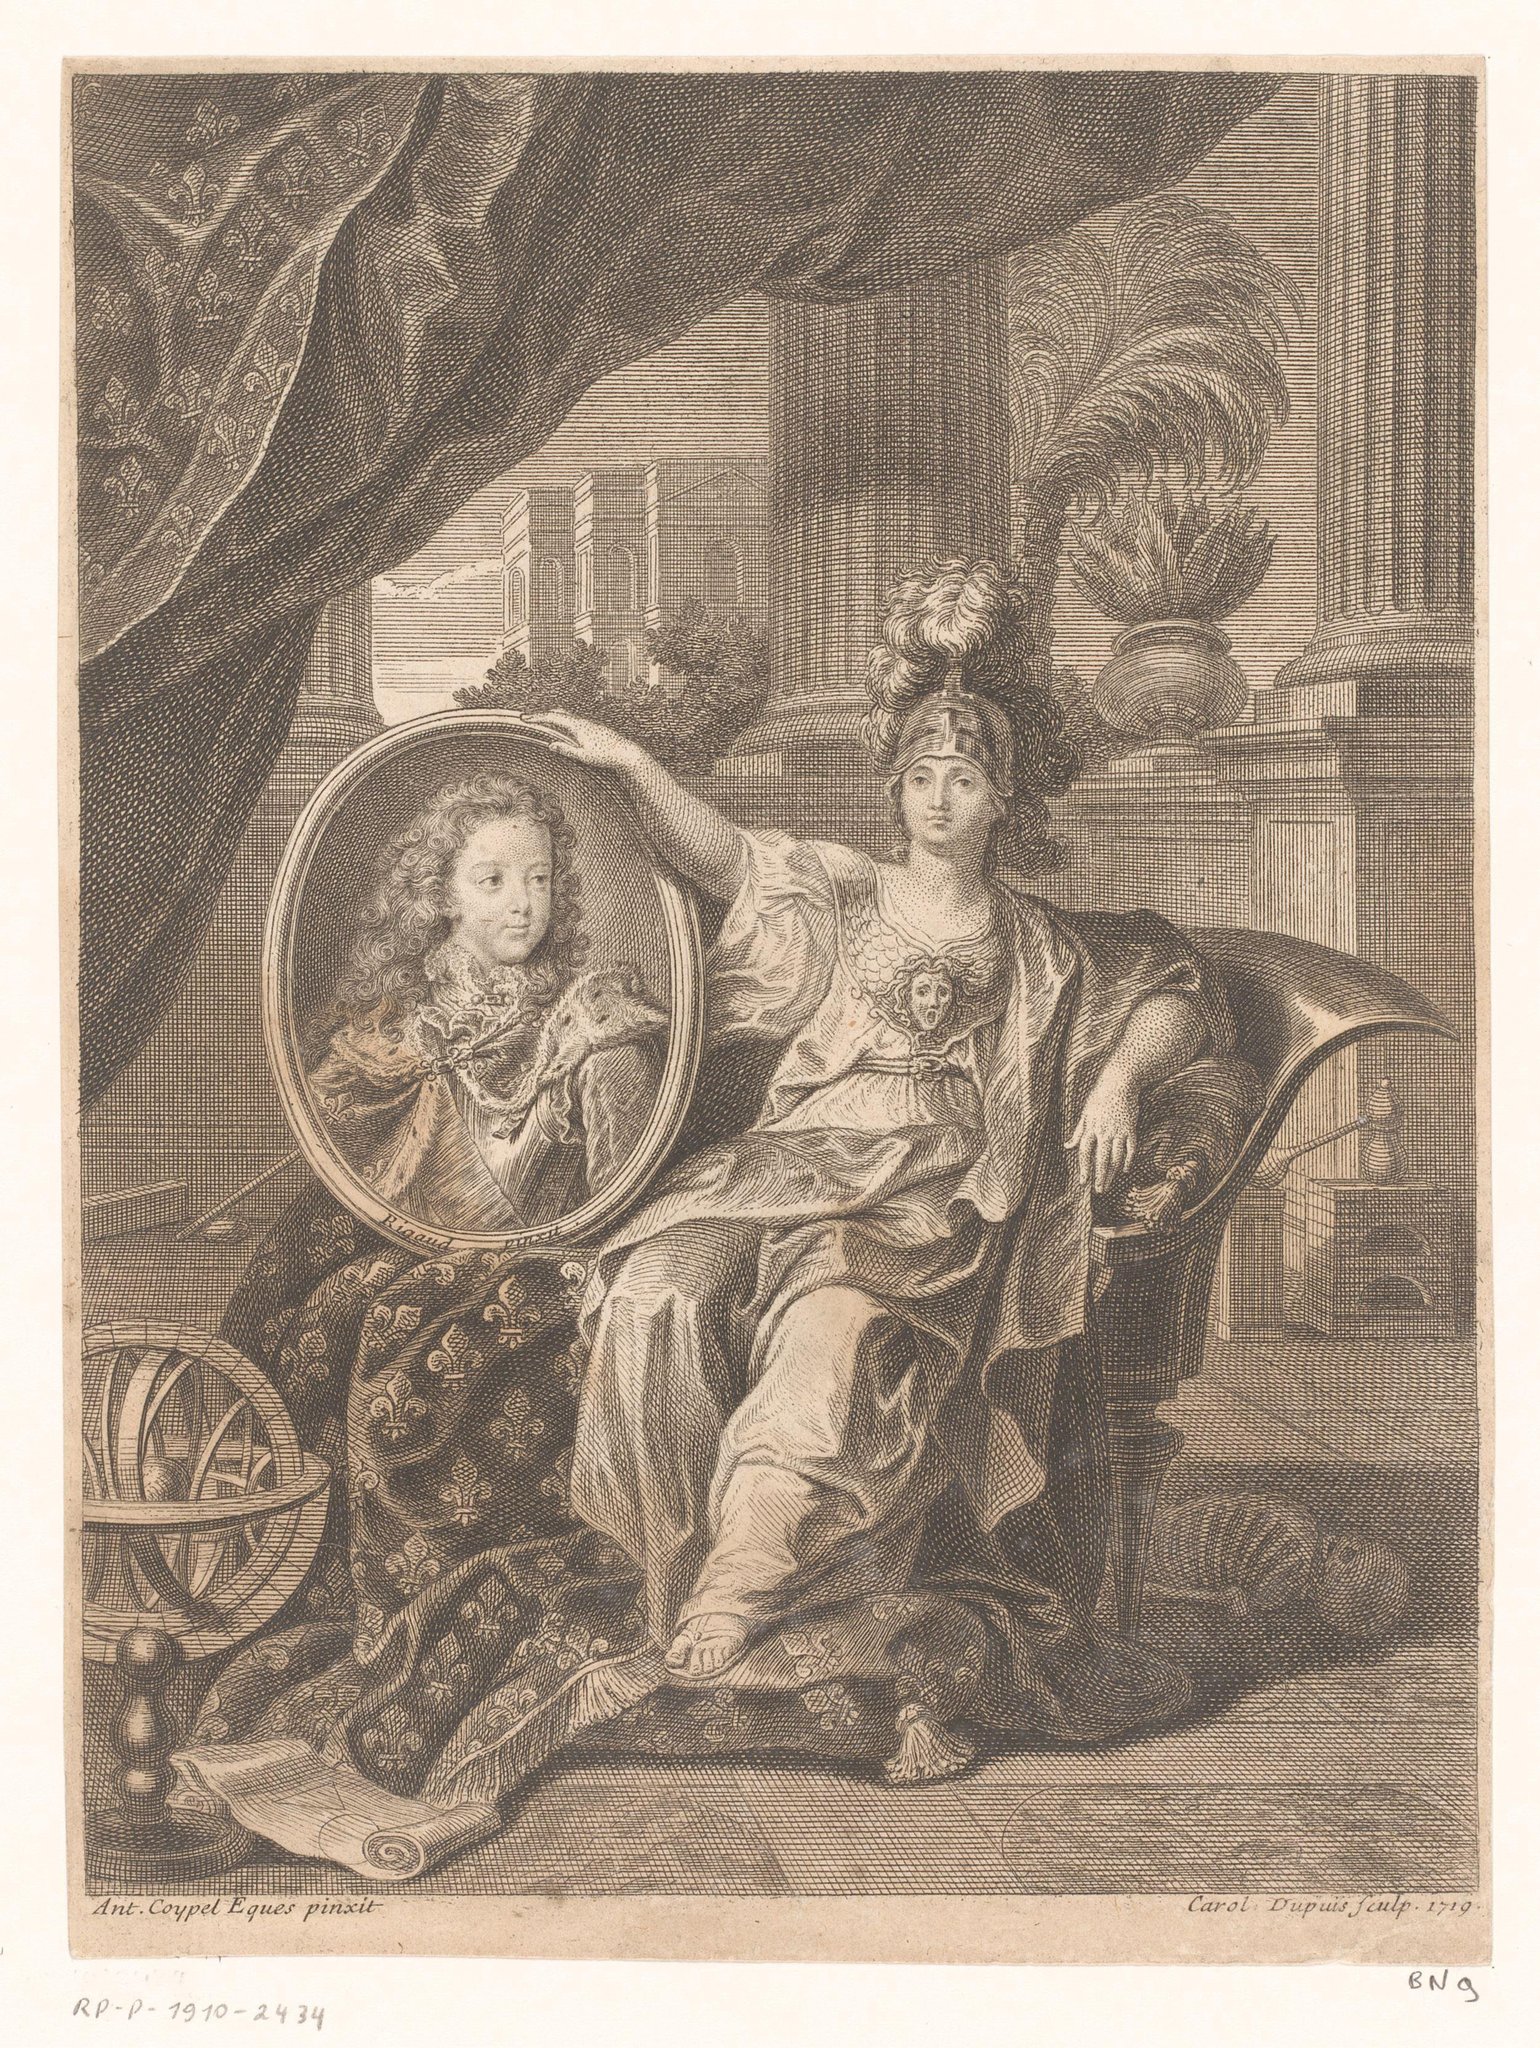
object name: print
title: Minerva met het portret van de jonge Lodewijk XV van Frankrijk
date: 1719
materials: paper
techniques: engraving, etching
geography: france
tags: louis xv of france, (story of) minerva (pallas, athena), historical persons, (human) skeleton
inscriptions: collector's mark: Lugt 2228